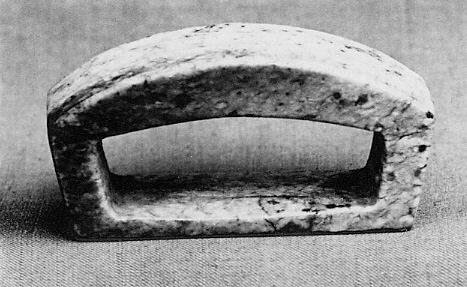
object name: scabbard slide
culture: chinese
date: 400-301 BCE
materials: jade